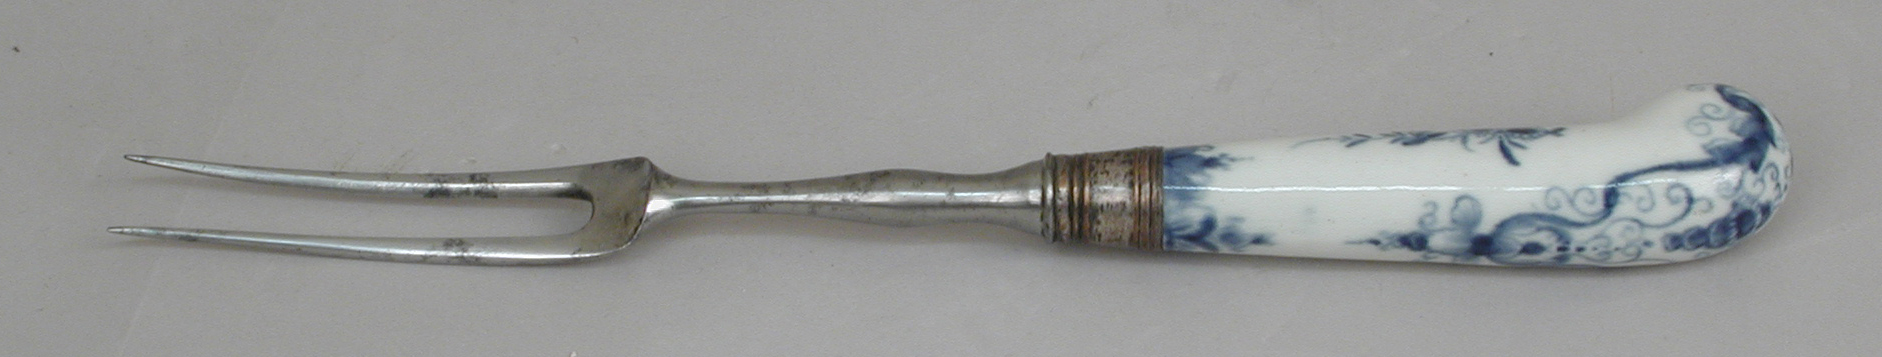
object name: fork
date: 1801-1900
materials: porcelain, steel